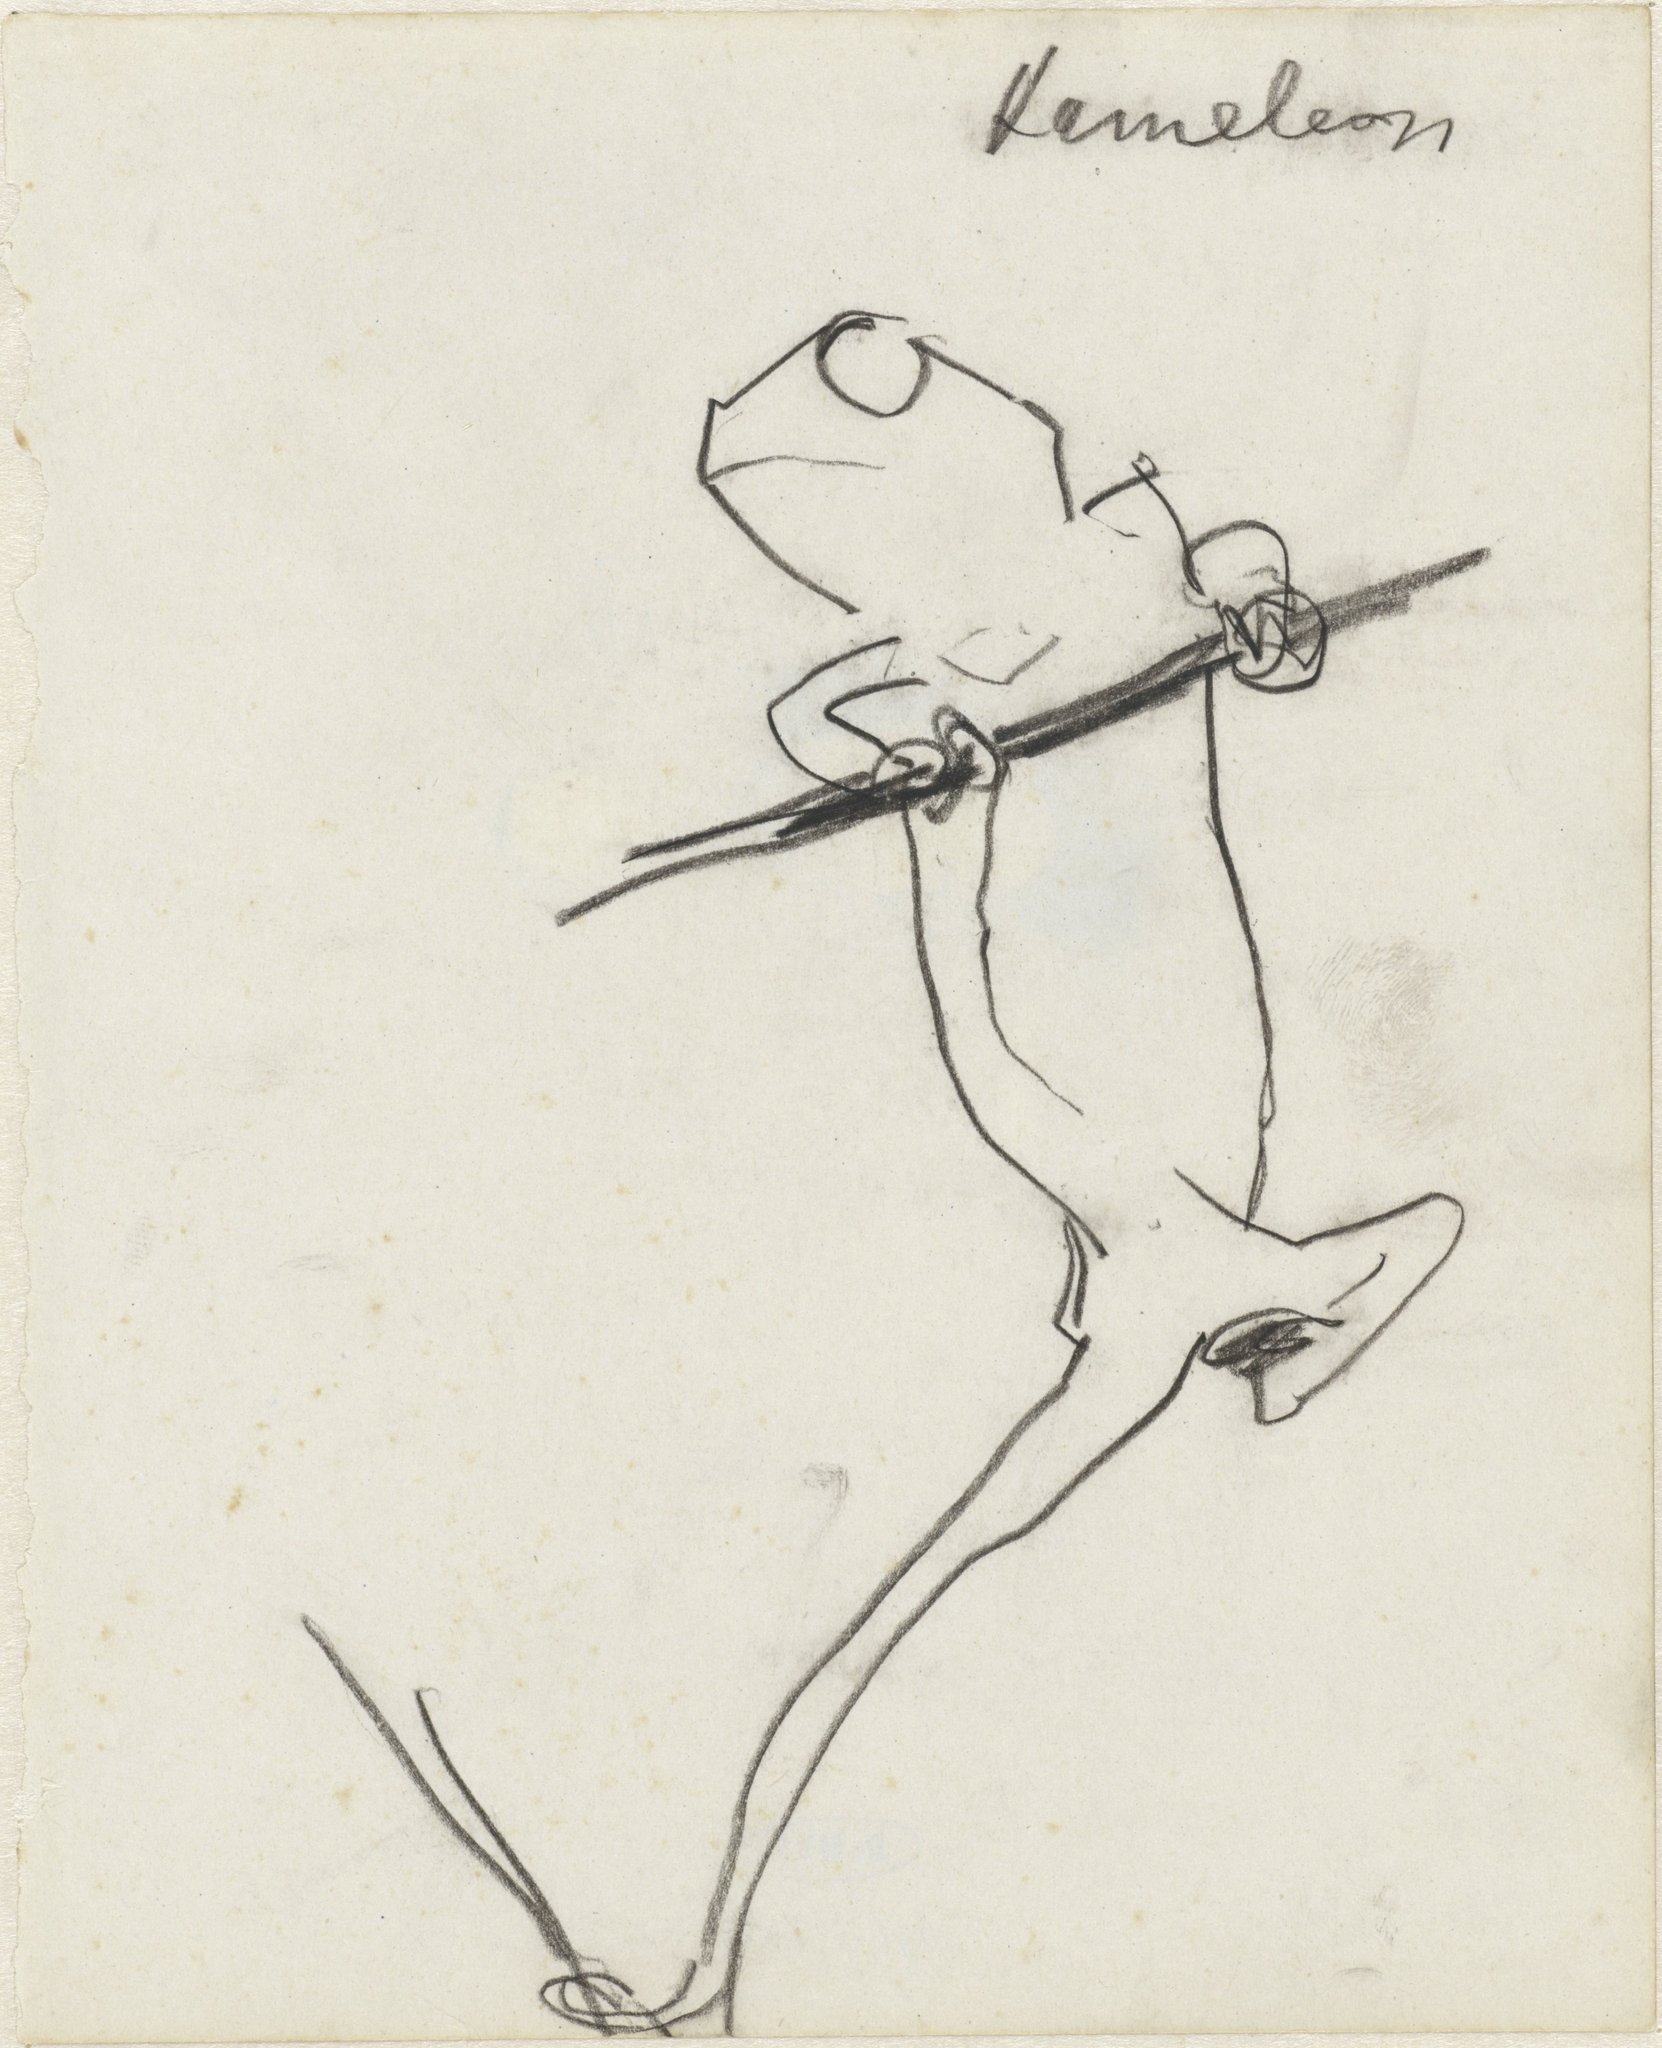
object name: drawing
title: Kameleon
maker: theo nieuwenhuis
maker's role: designer, draughtsman, print maker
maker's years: 1866-1951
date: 1876-1951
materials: chalk, paper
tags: lizards: chameleon